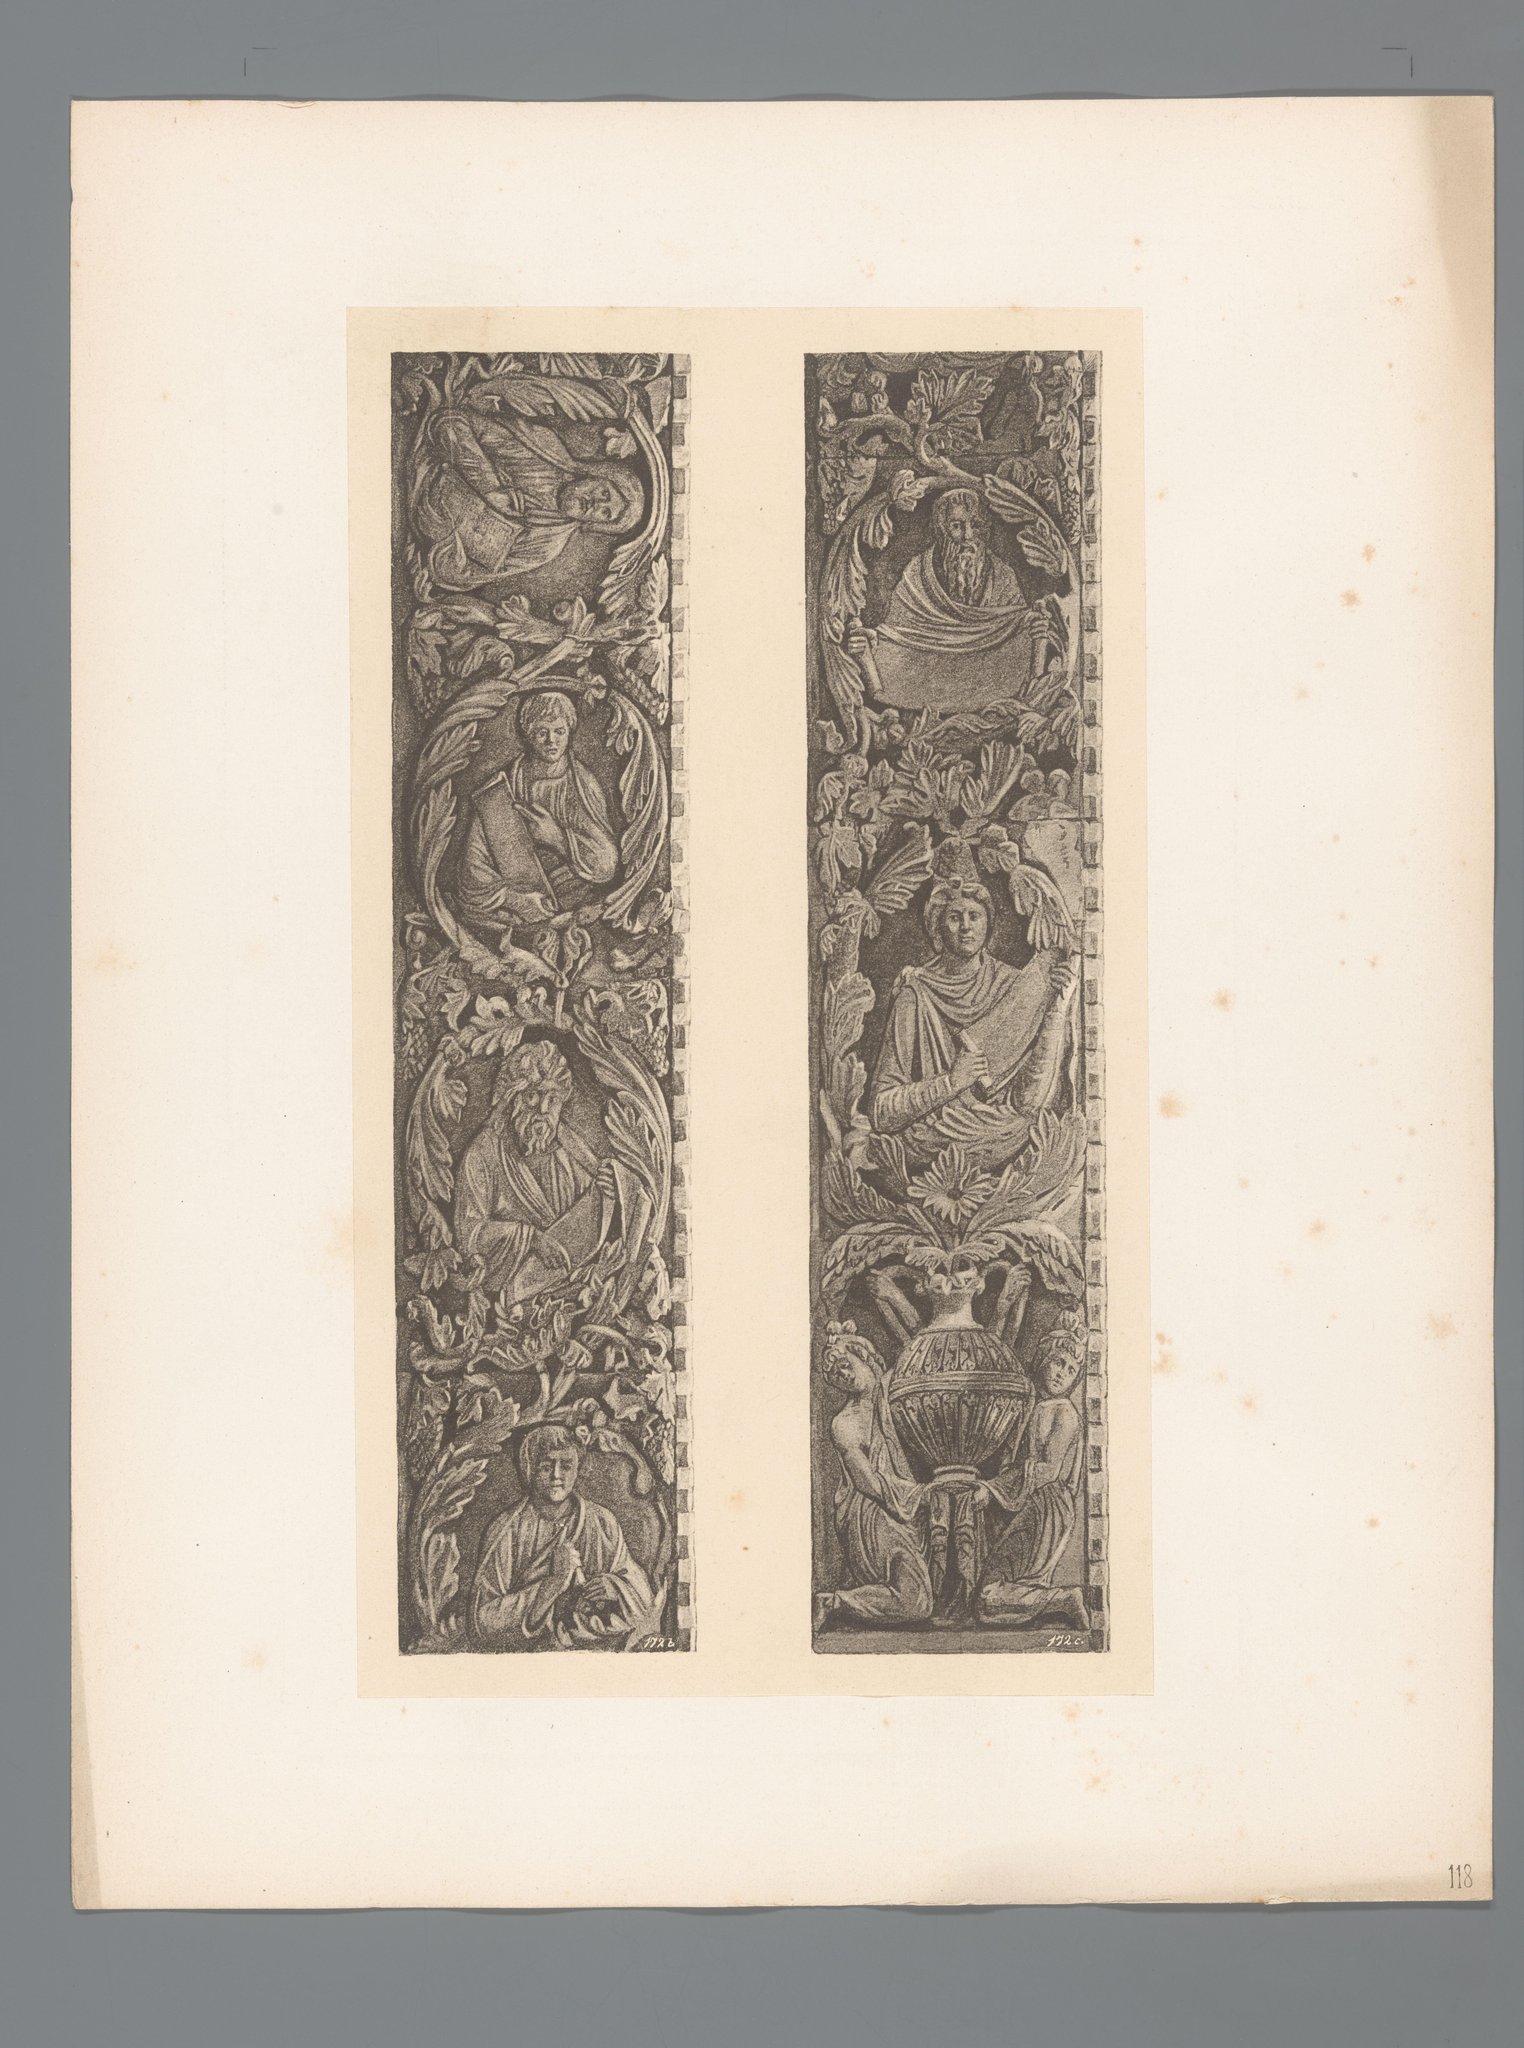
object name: photomechanical print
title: Twee afbeeldingen van reliëfs, vermoedelijk van apostelen, van de San Marco in Venetië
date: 1879-1884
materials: paper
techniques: photograph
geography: venice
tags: the twelve apostles (as a group), usually with books or scrolls (not in biblical context)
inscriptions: number: ‘172b’, number: ‘118’, number: ‘172c’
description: Deze prenten maken deel uit van een omslag met 51 prenten op 29 bladen en 1 tekstblad.